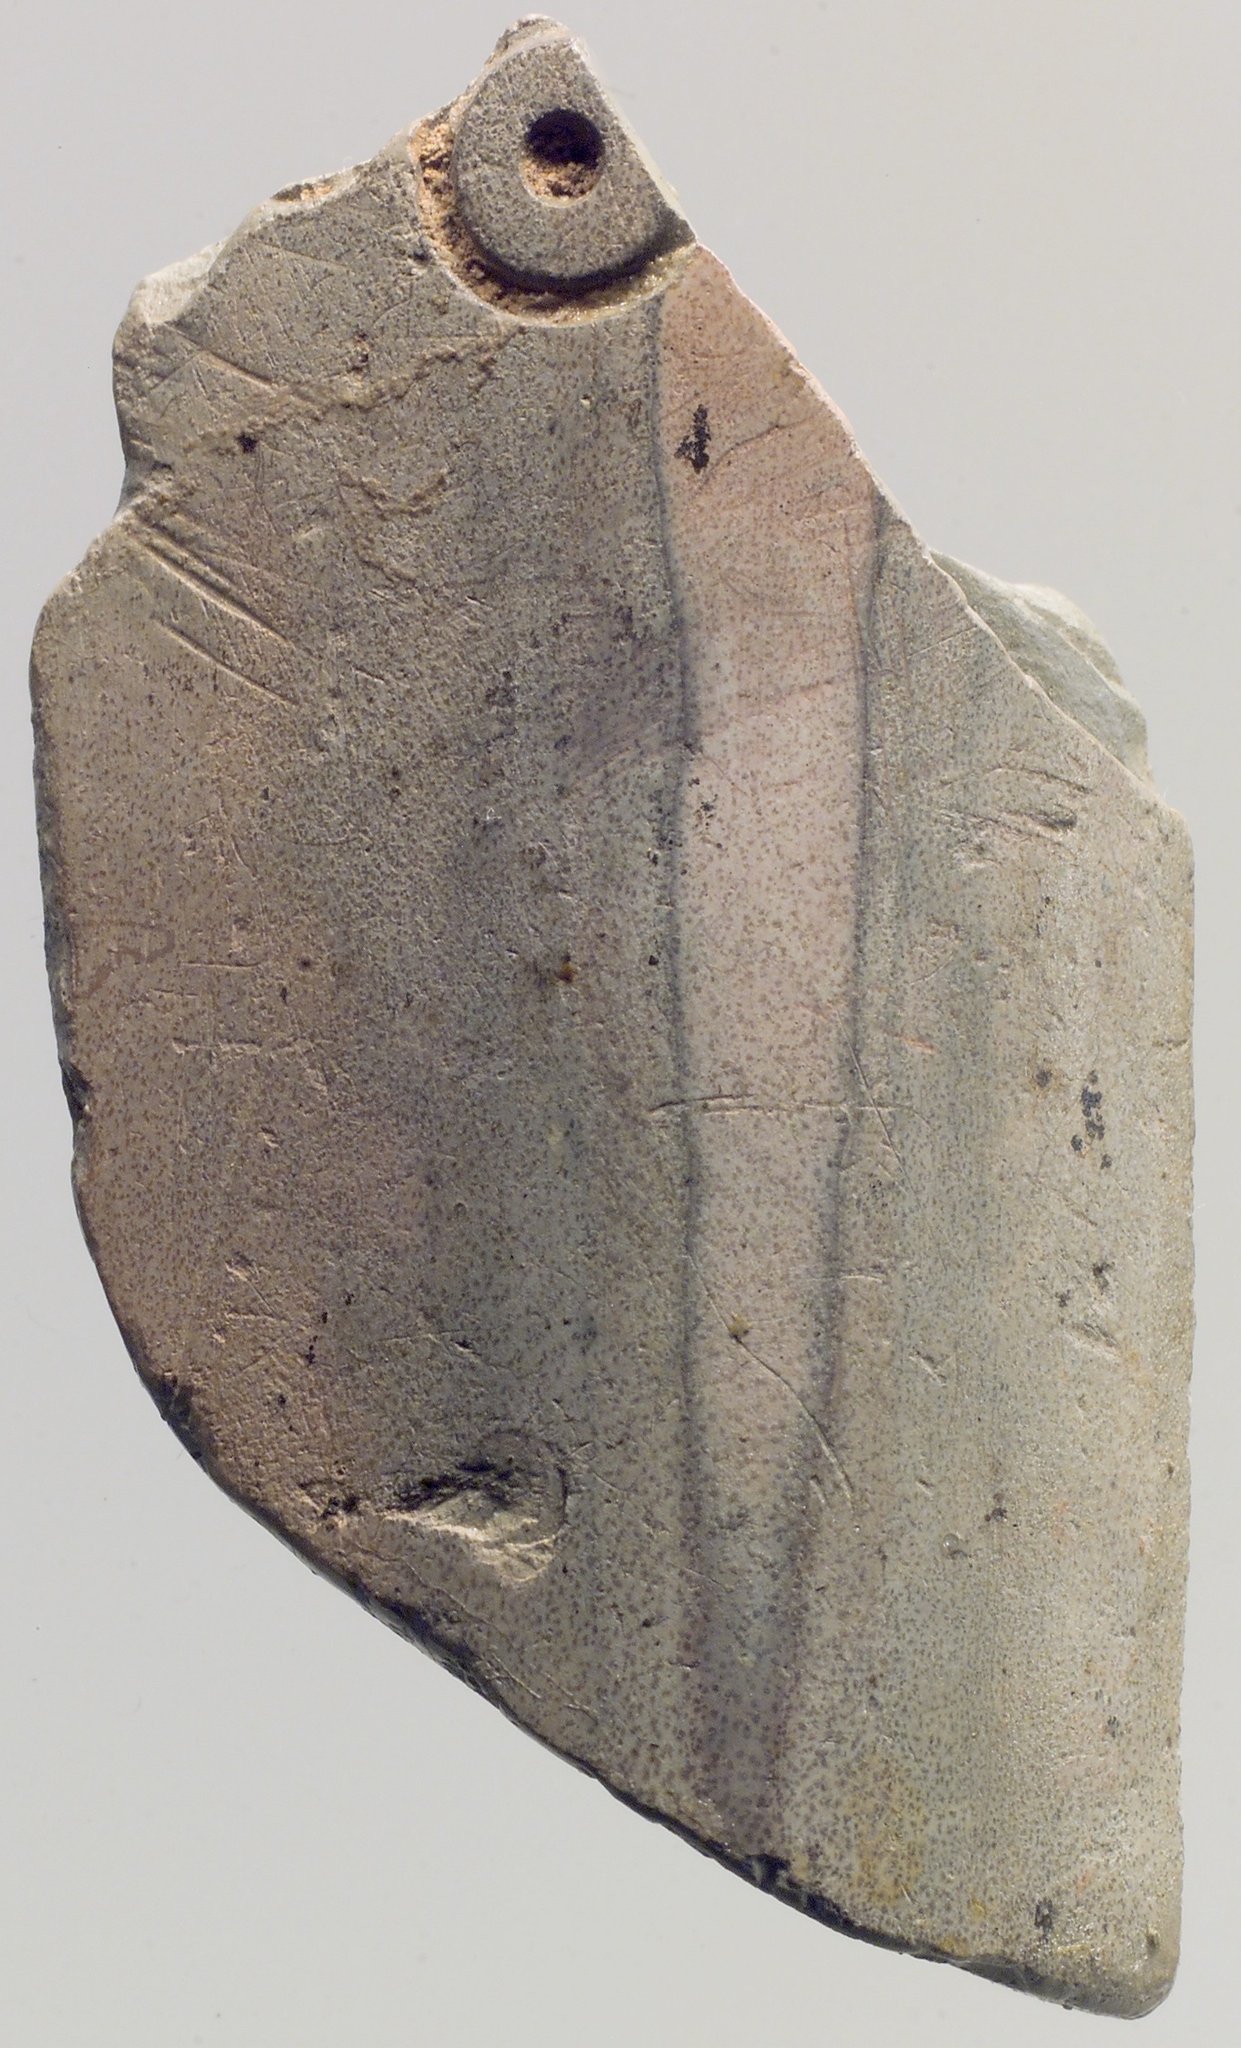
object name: relief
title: Plaque fragment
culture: assyrian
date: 1800-1701 BCE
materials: ivory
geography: anatolia